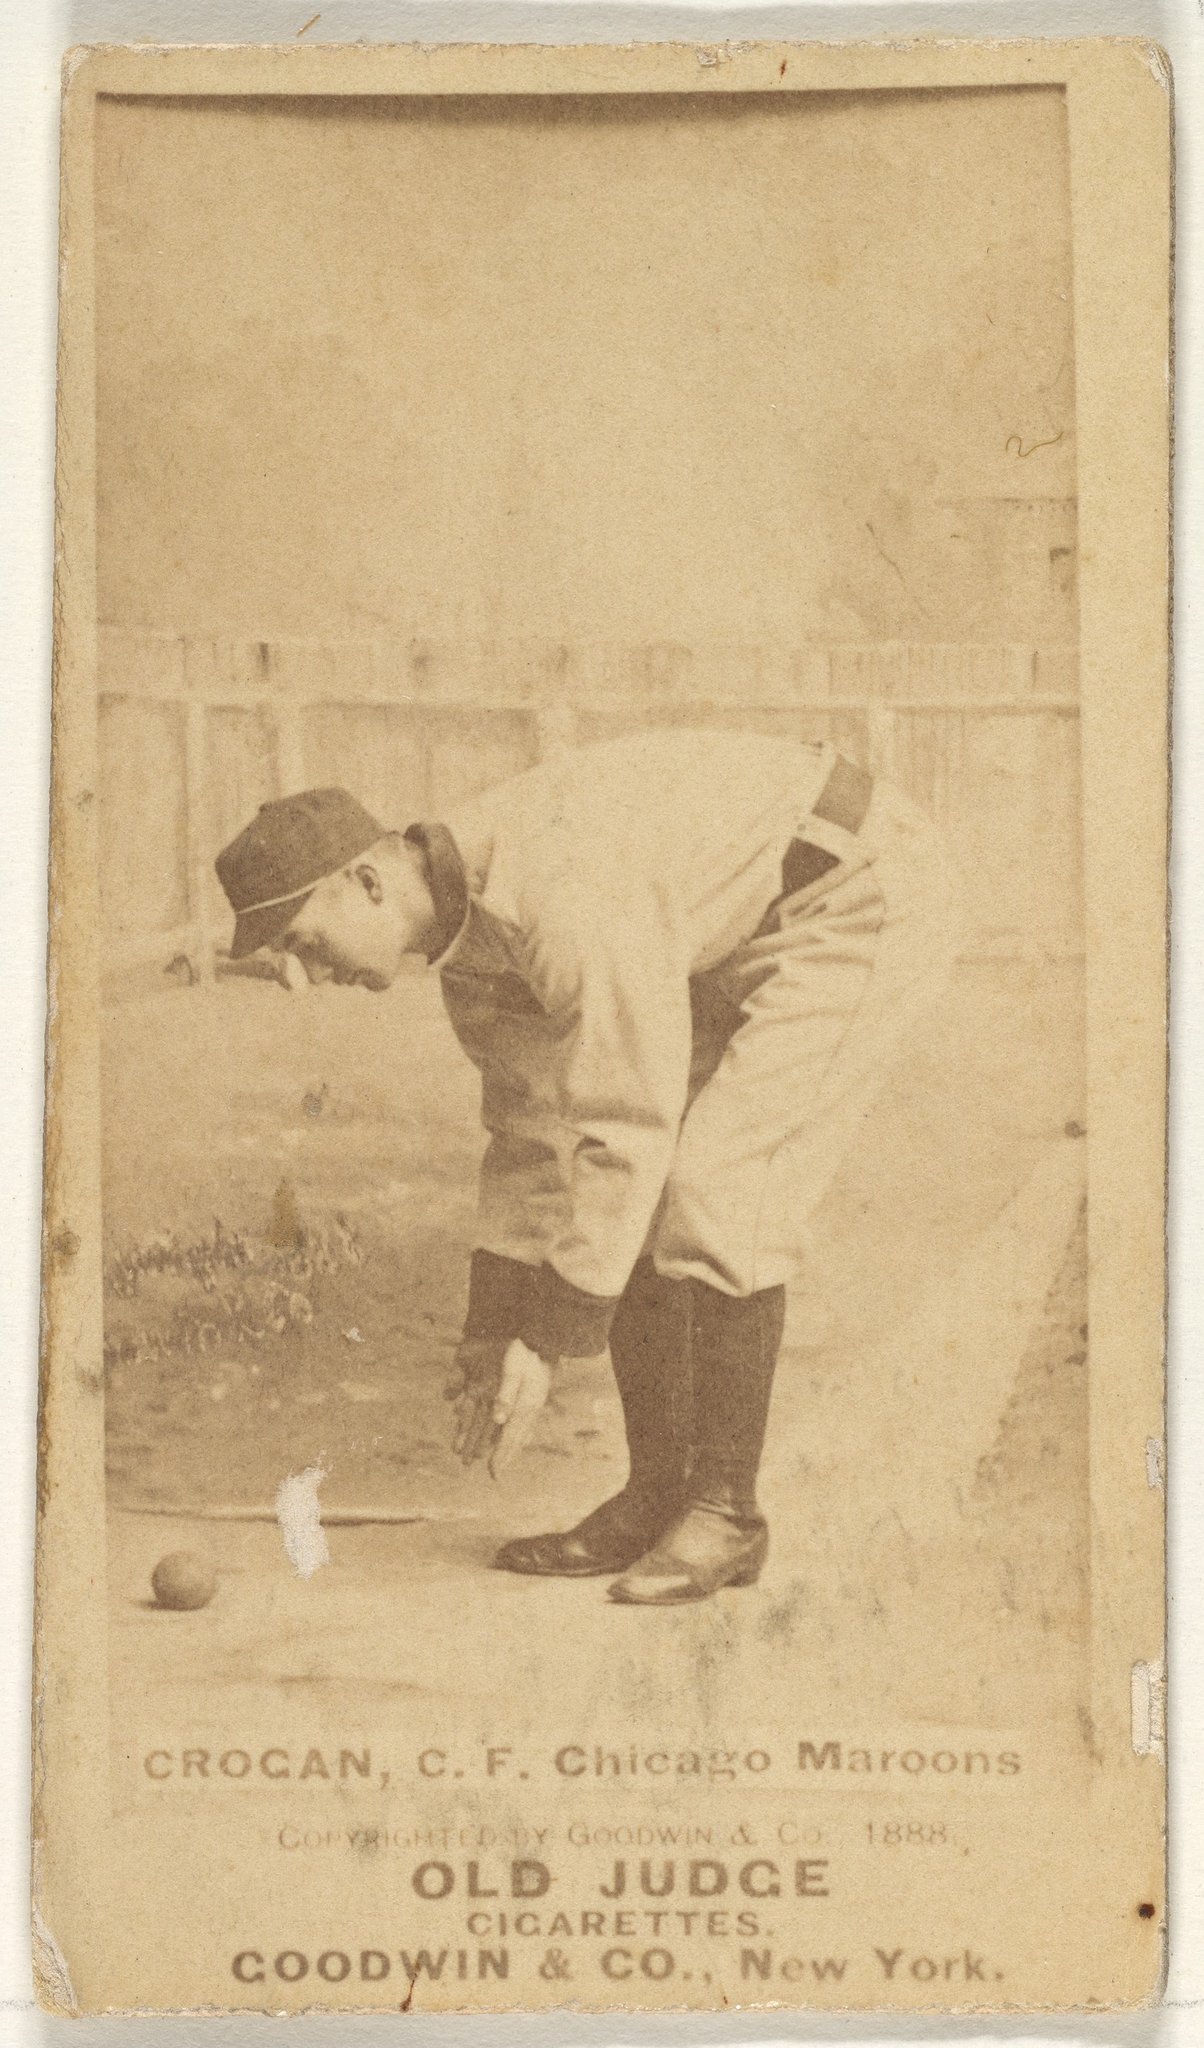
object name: baseball card, photograph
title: Crocan, Center Field, Chicago, from the Old Judge series (N172) for Old Judge Cigarettes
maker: goodwin & company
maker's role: publisher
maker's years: 1850-1950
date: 1888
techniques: albumen silver print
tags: men,portraits,baseball,athletes